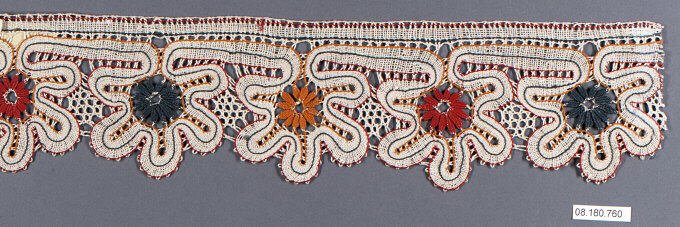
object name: fragment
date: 1801-1900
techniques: lace